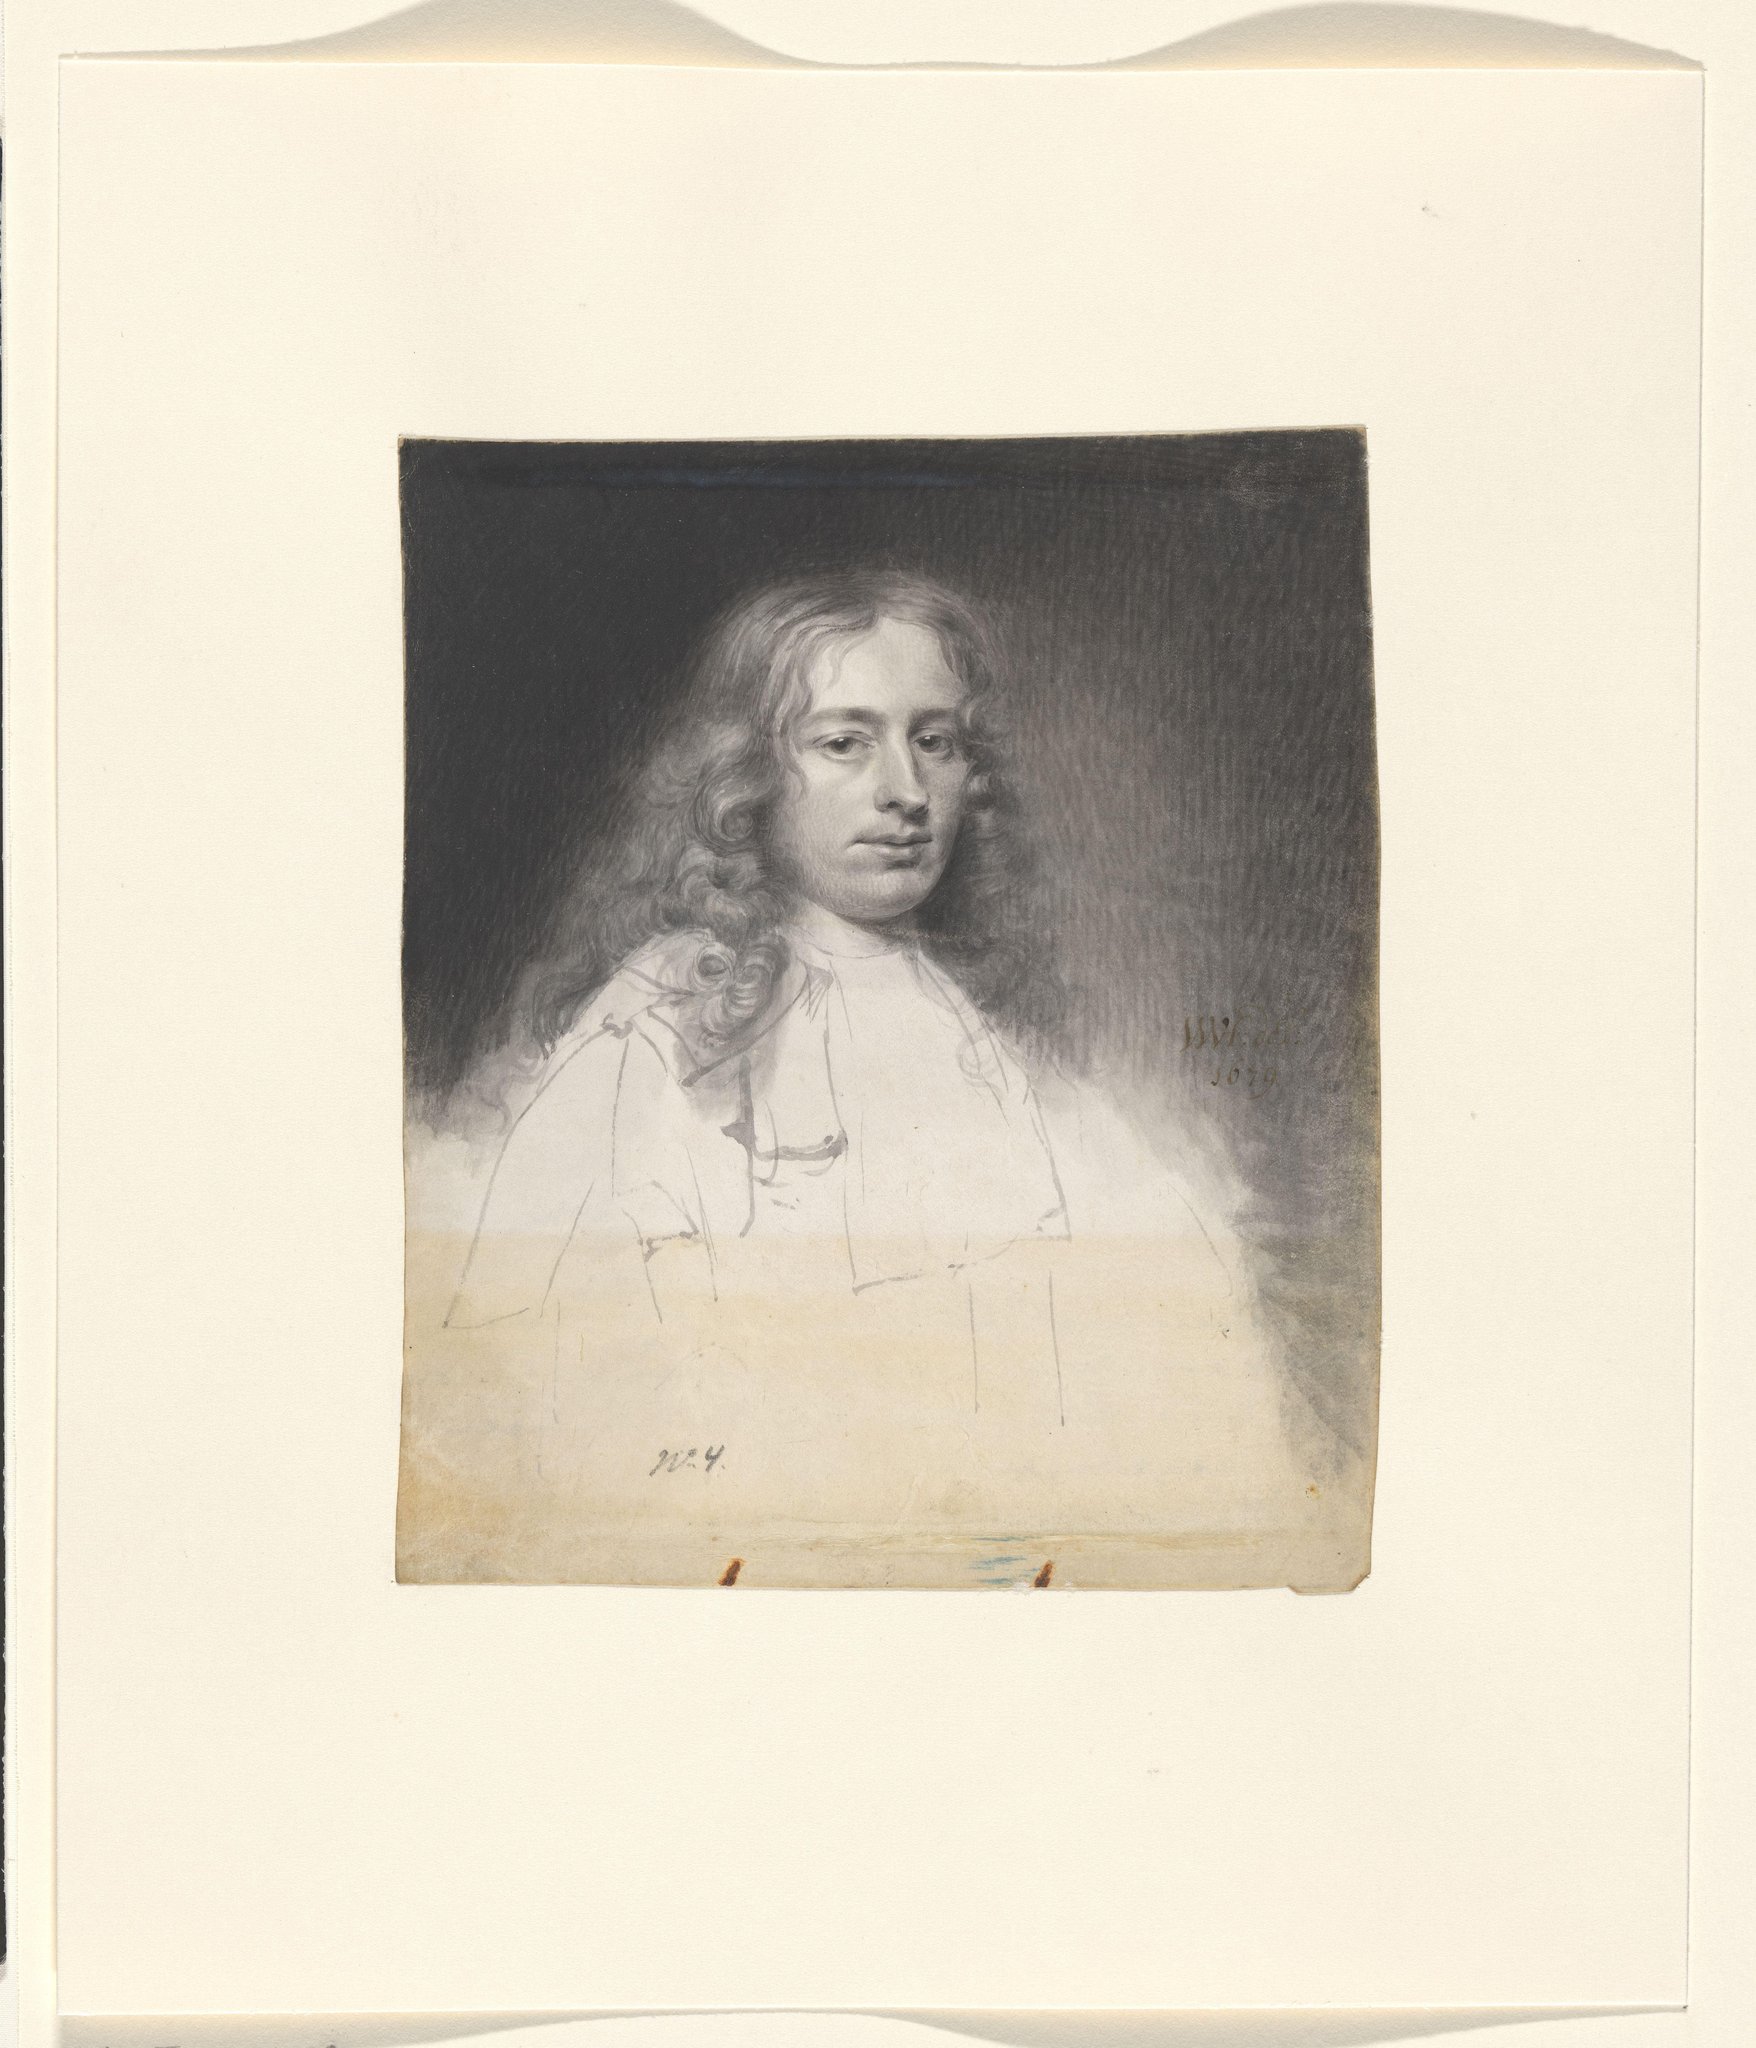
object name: drawing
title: Portret van Cornelis van der Hagen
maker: witte van der hagen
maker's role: draughtsman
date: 1679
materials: parchment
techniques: brush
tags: historical persons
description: Portret van Cornelis van der Hagen, burgemeester van Brielle.